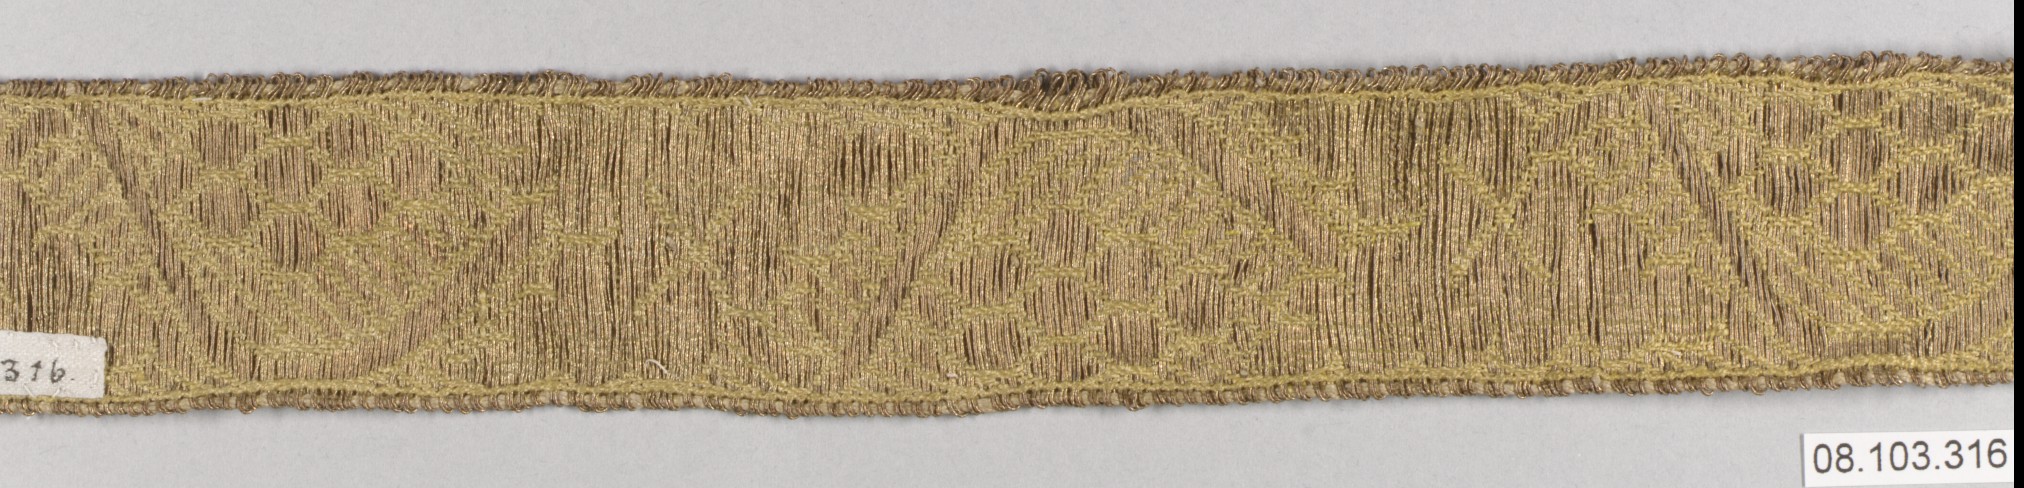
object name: galloon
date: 1701-1800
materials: metal thread, silk